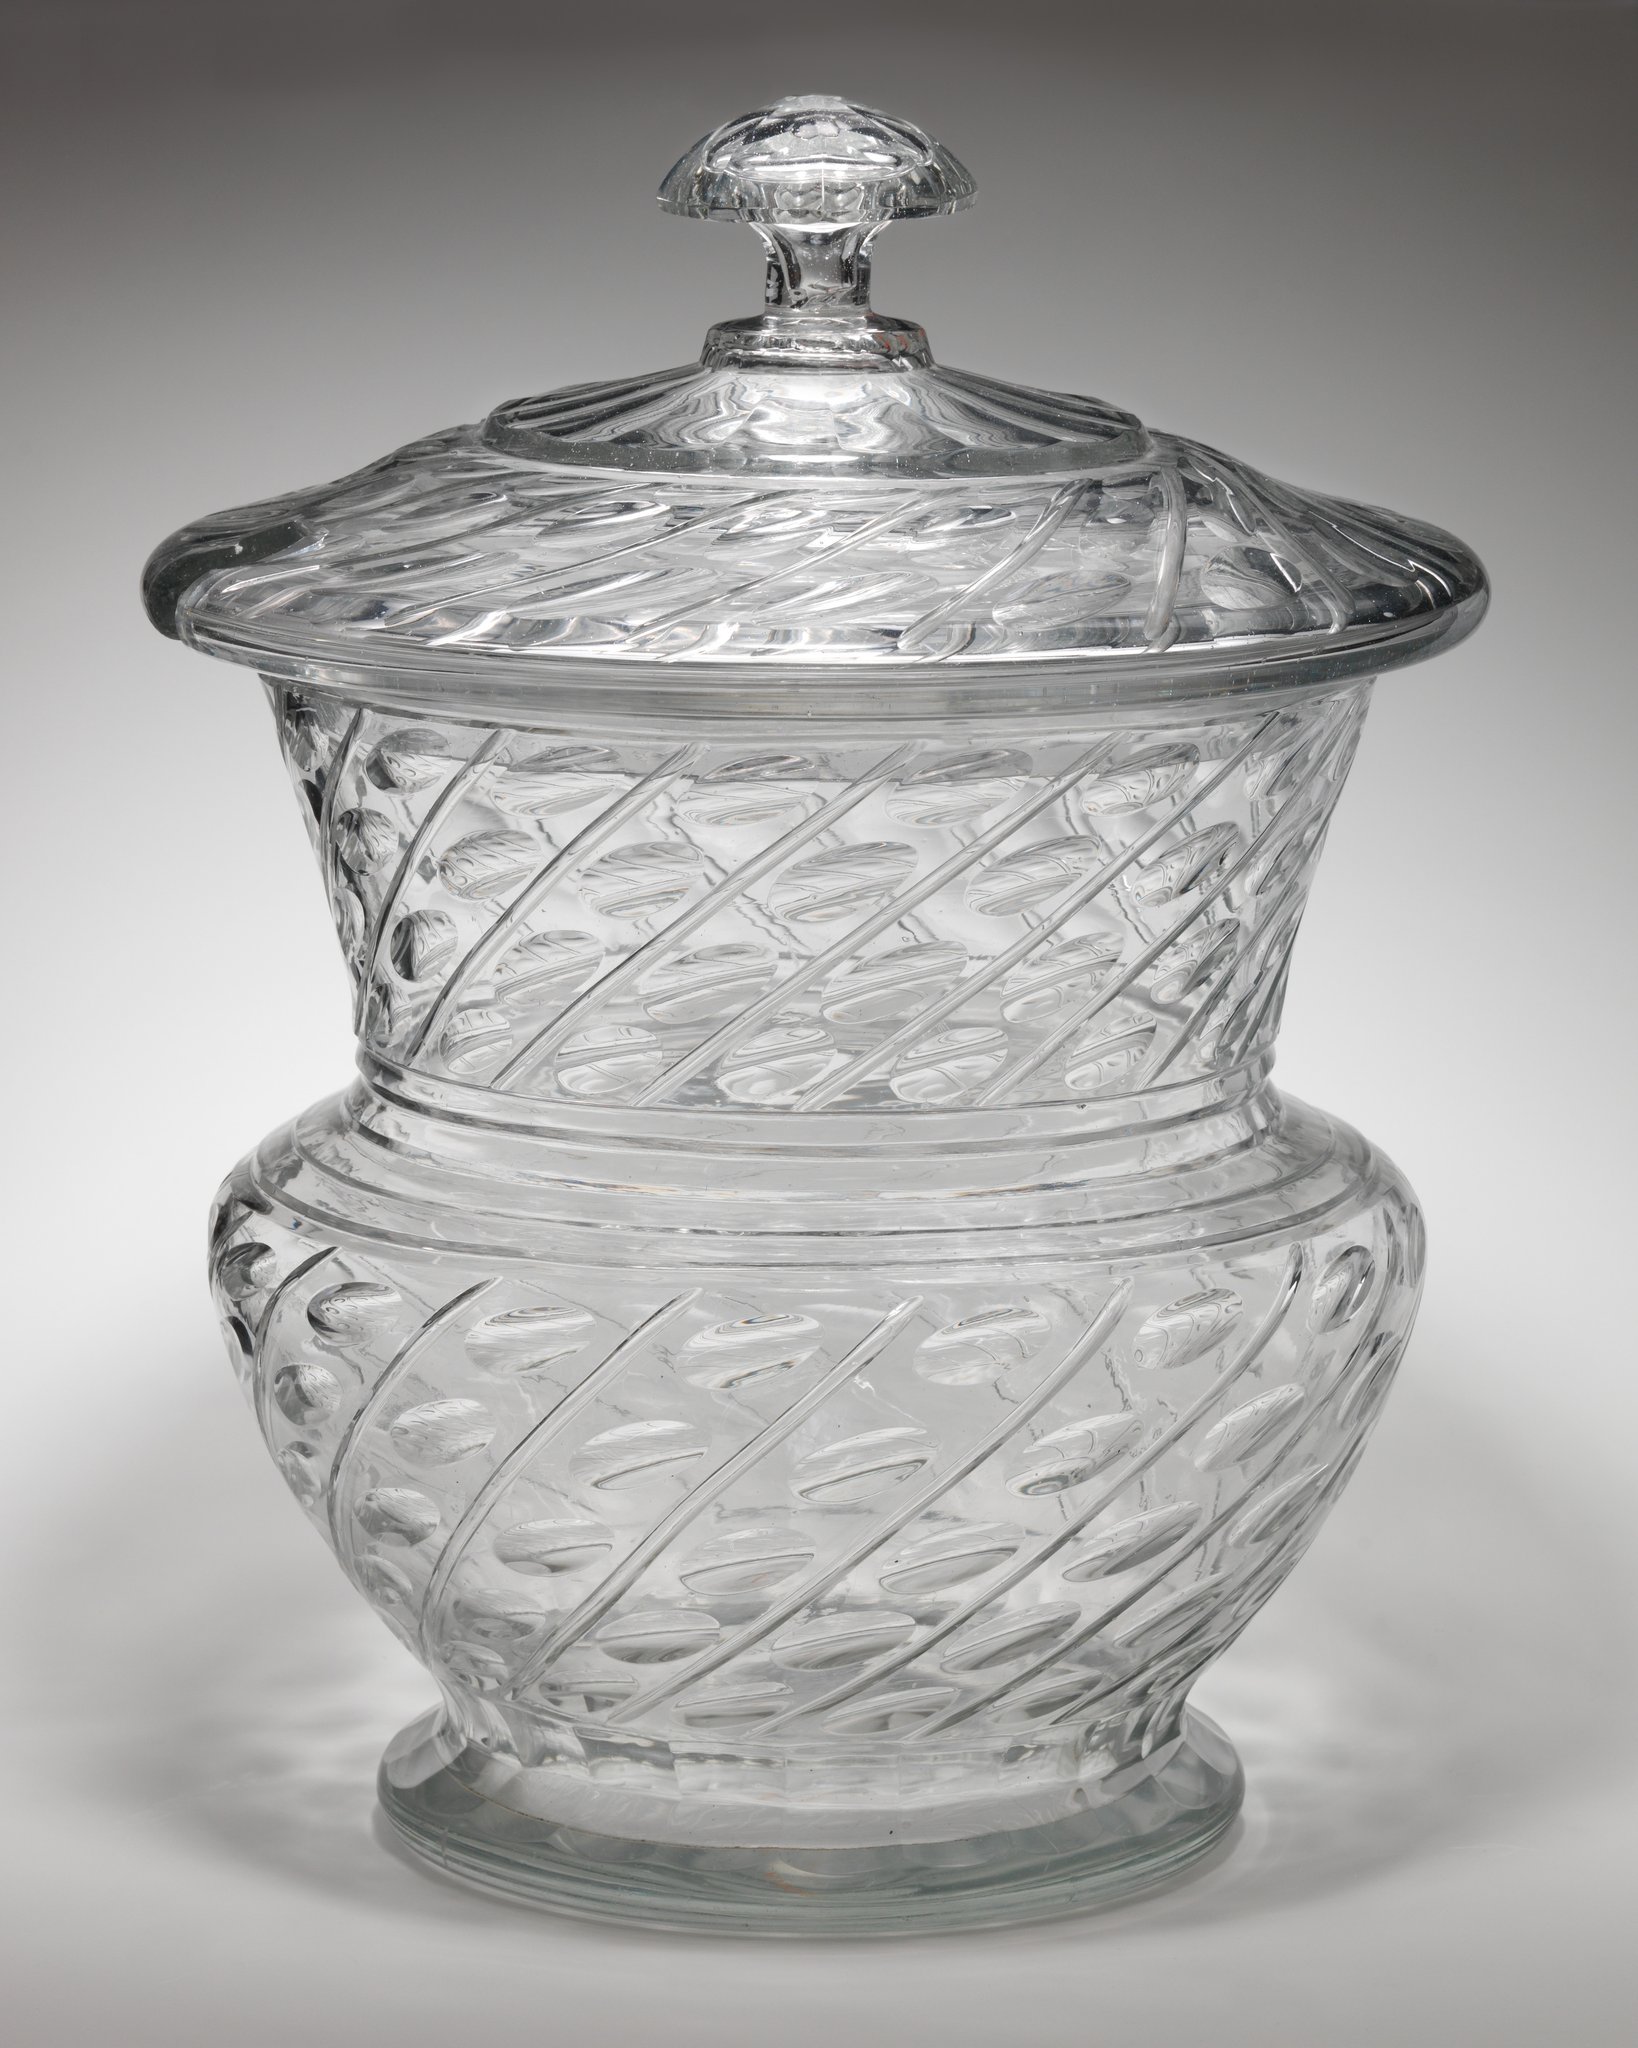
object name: punch bowl with cover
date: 1801-1850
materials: glass